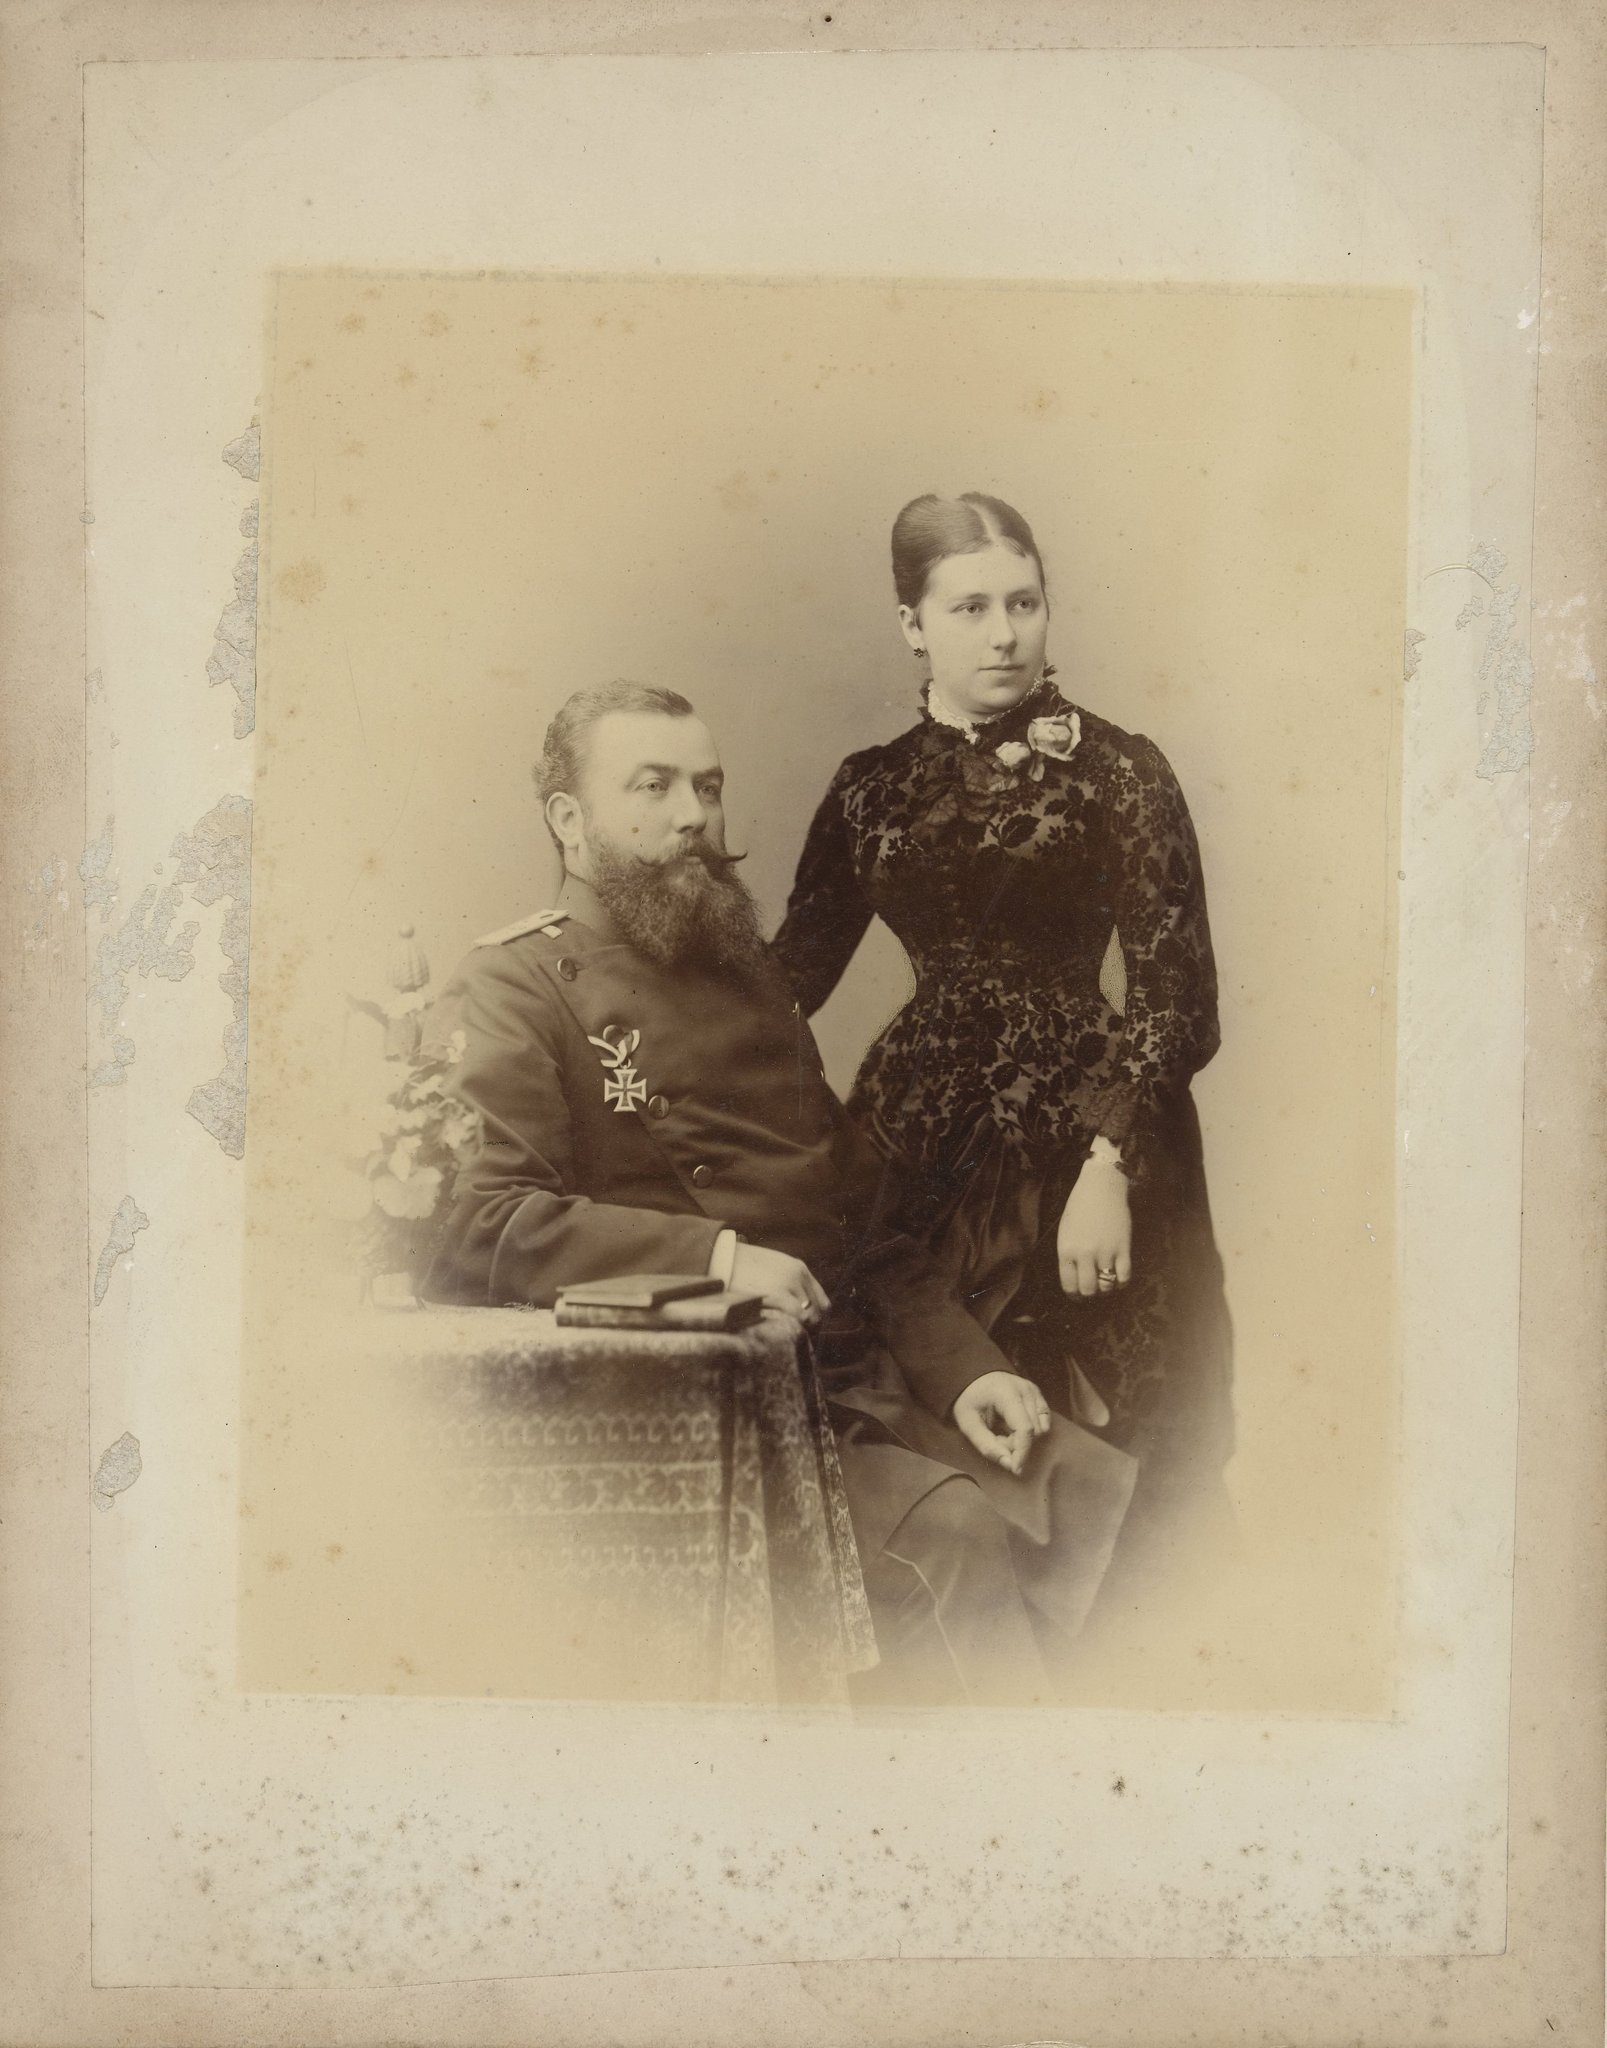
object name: photograph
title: Studioportret van een man met orde op zijn borst gespeld en een vrouw aan zijn zijde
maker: Anonymous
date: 1880-1900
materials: cardboard, photographic support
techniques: albumen print